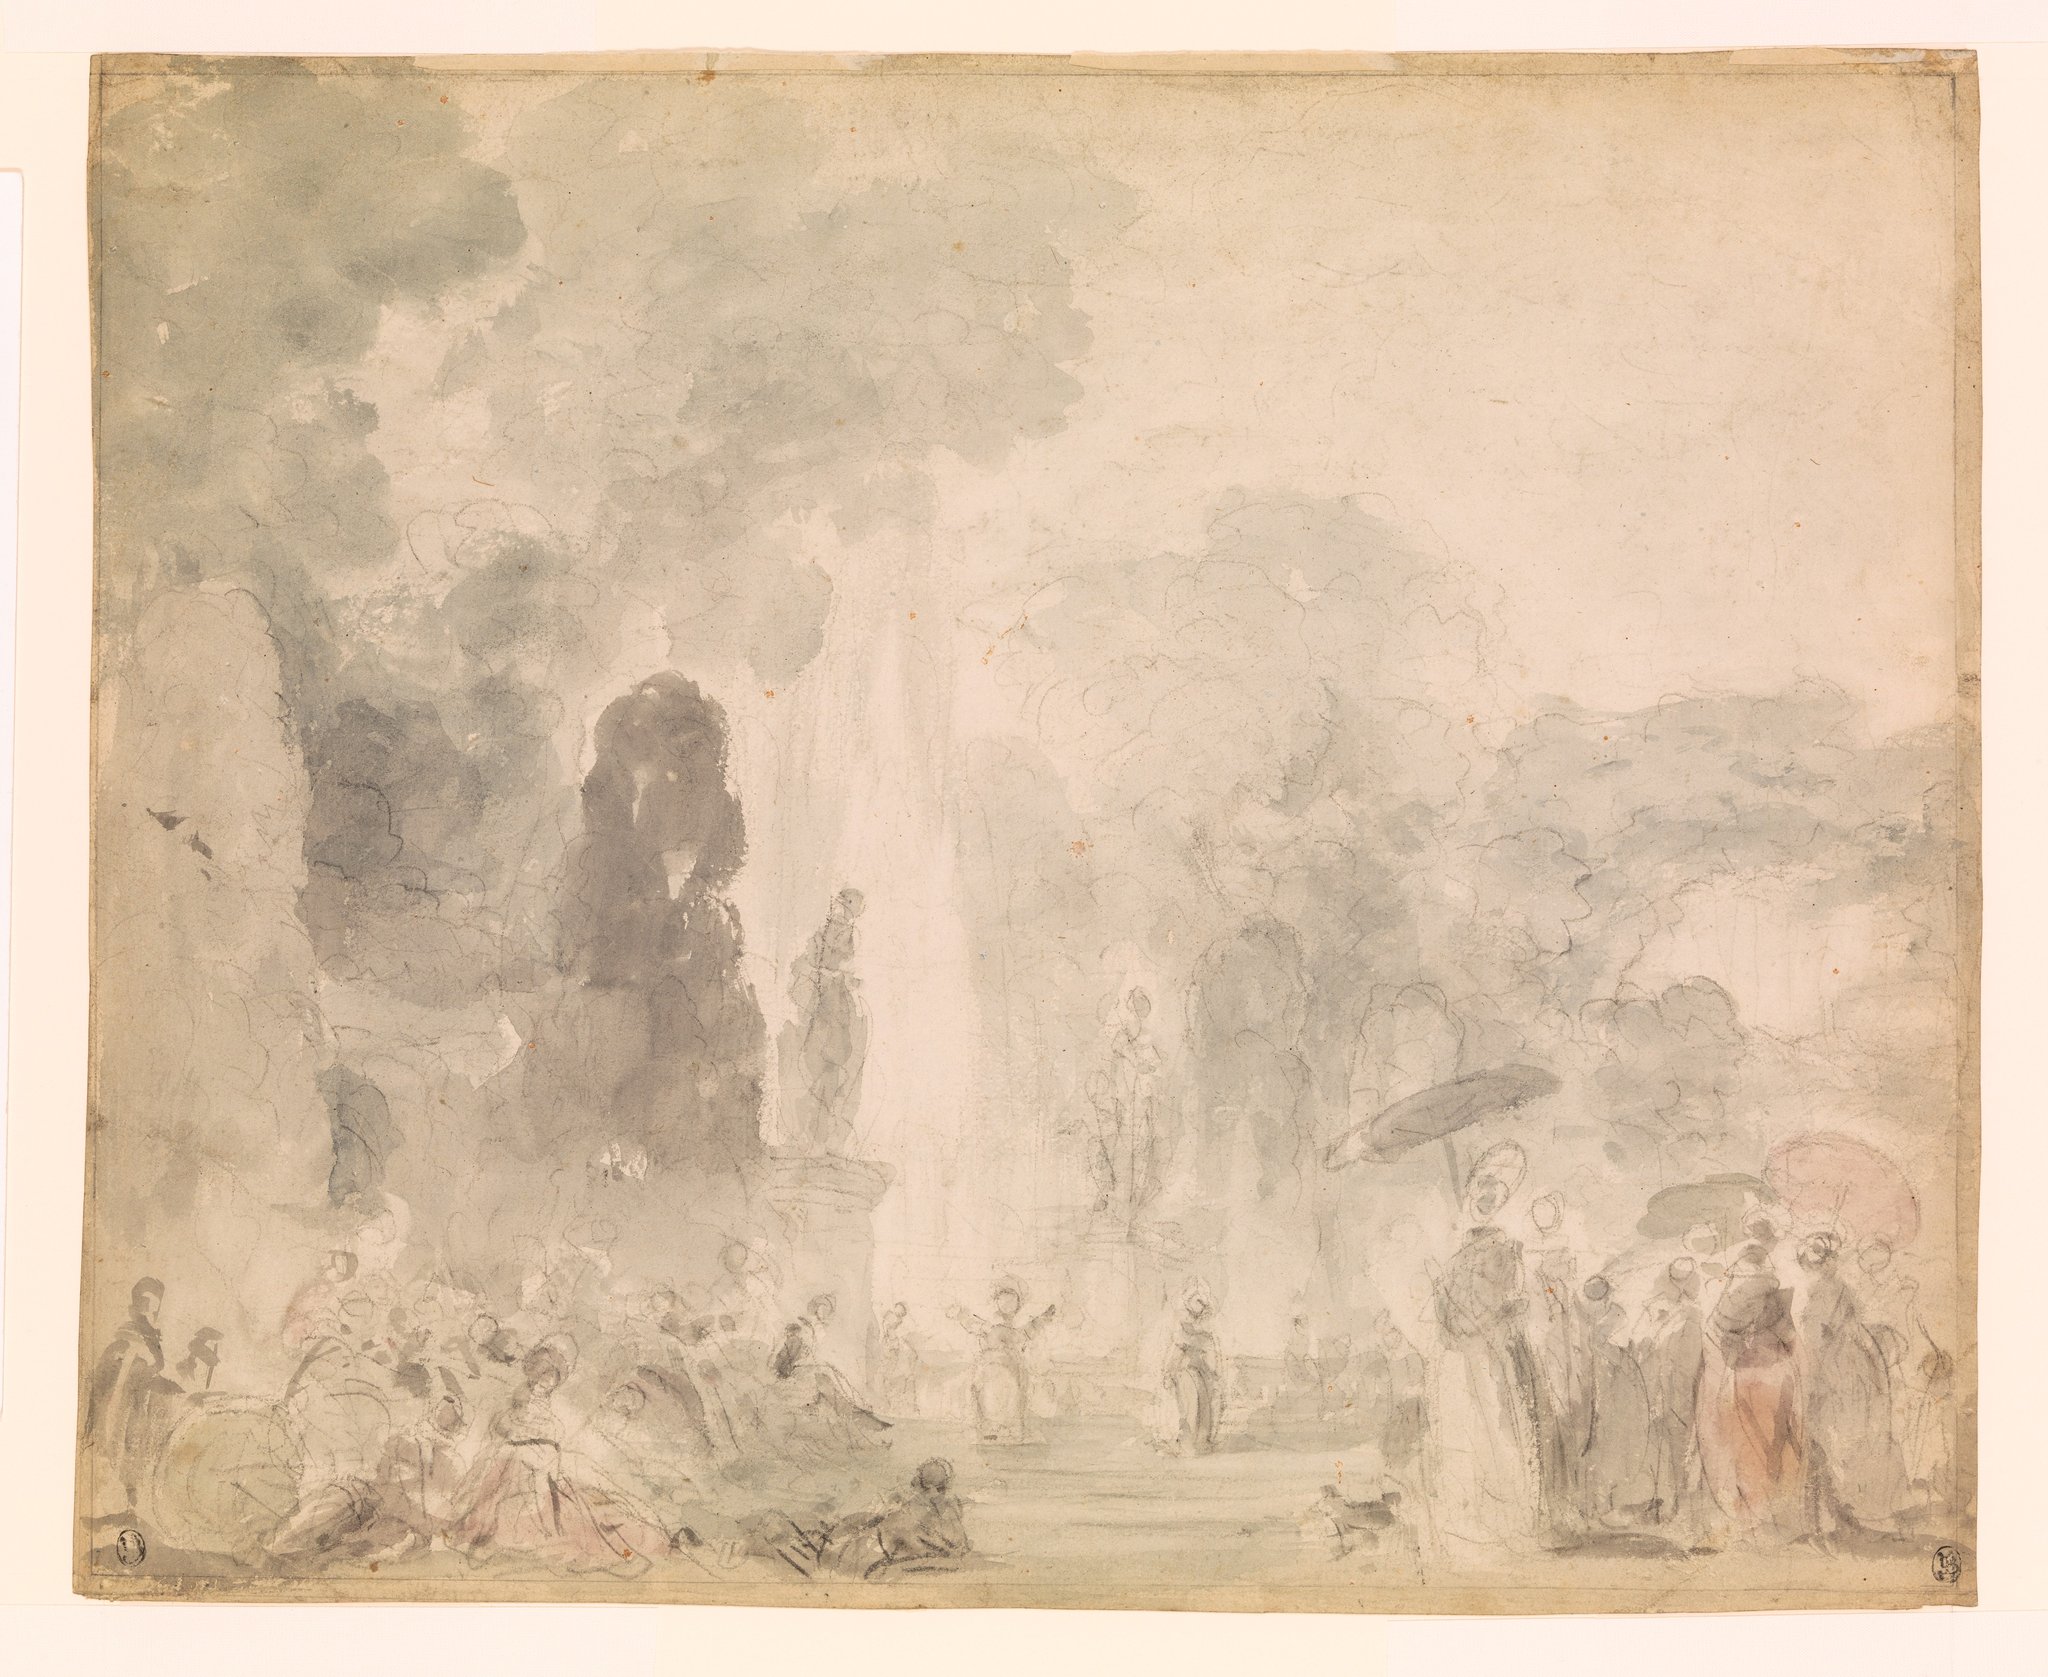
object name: drawing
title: View of a Park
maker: jean honoré fragonard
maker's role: artist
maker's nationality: french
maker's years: 1732-1806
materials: chalk, pencil, watercolor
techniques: drawing, wash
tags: parks